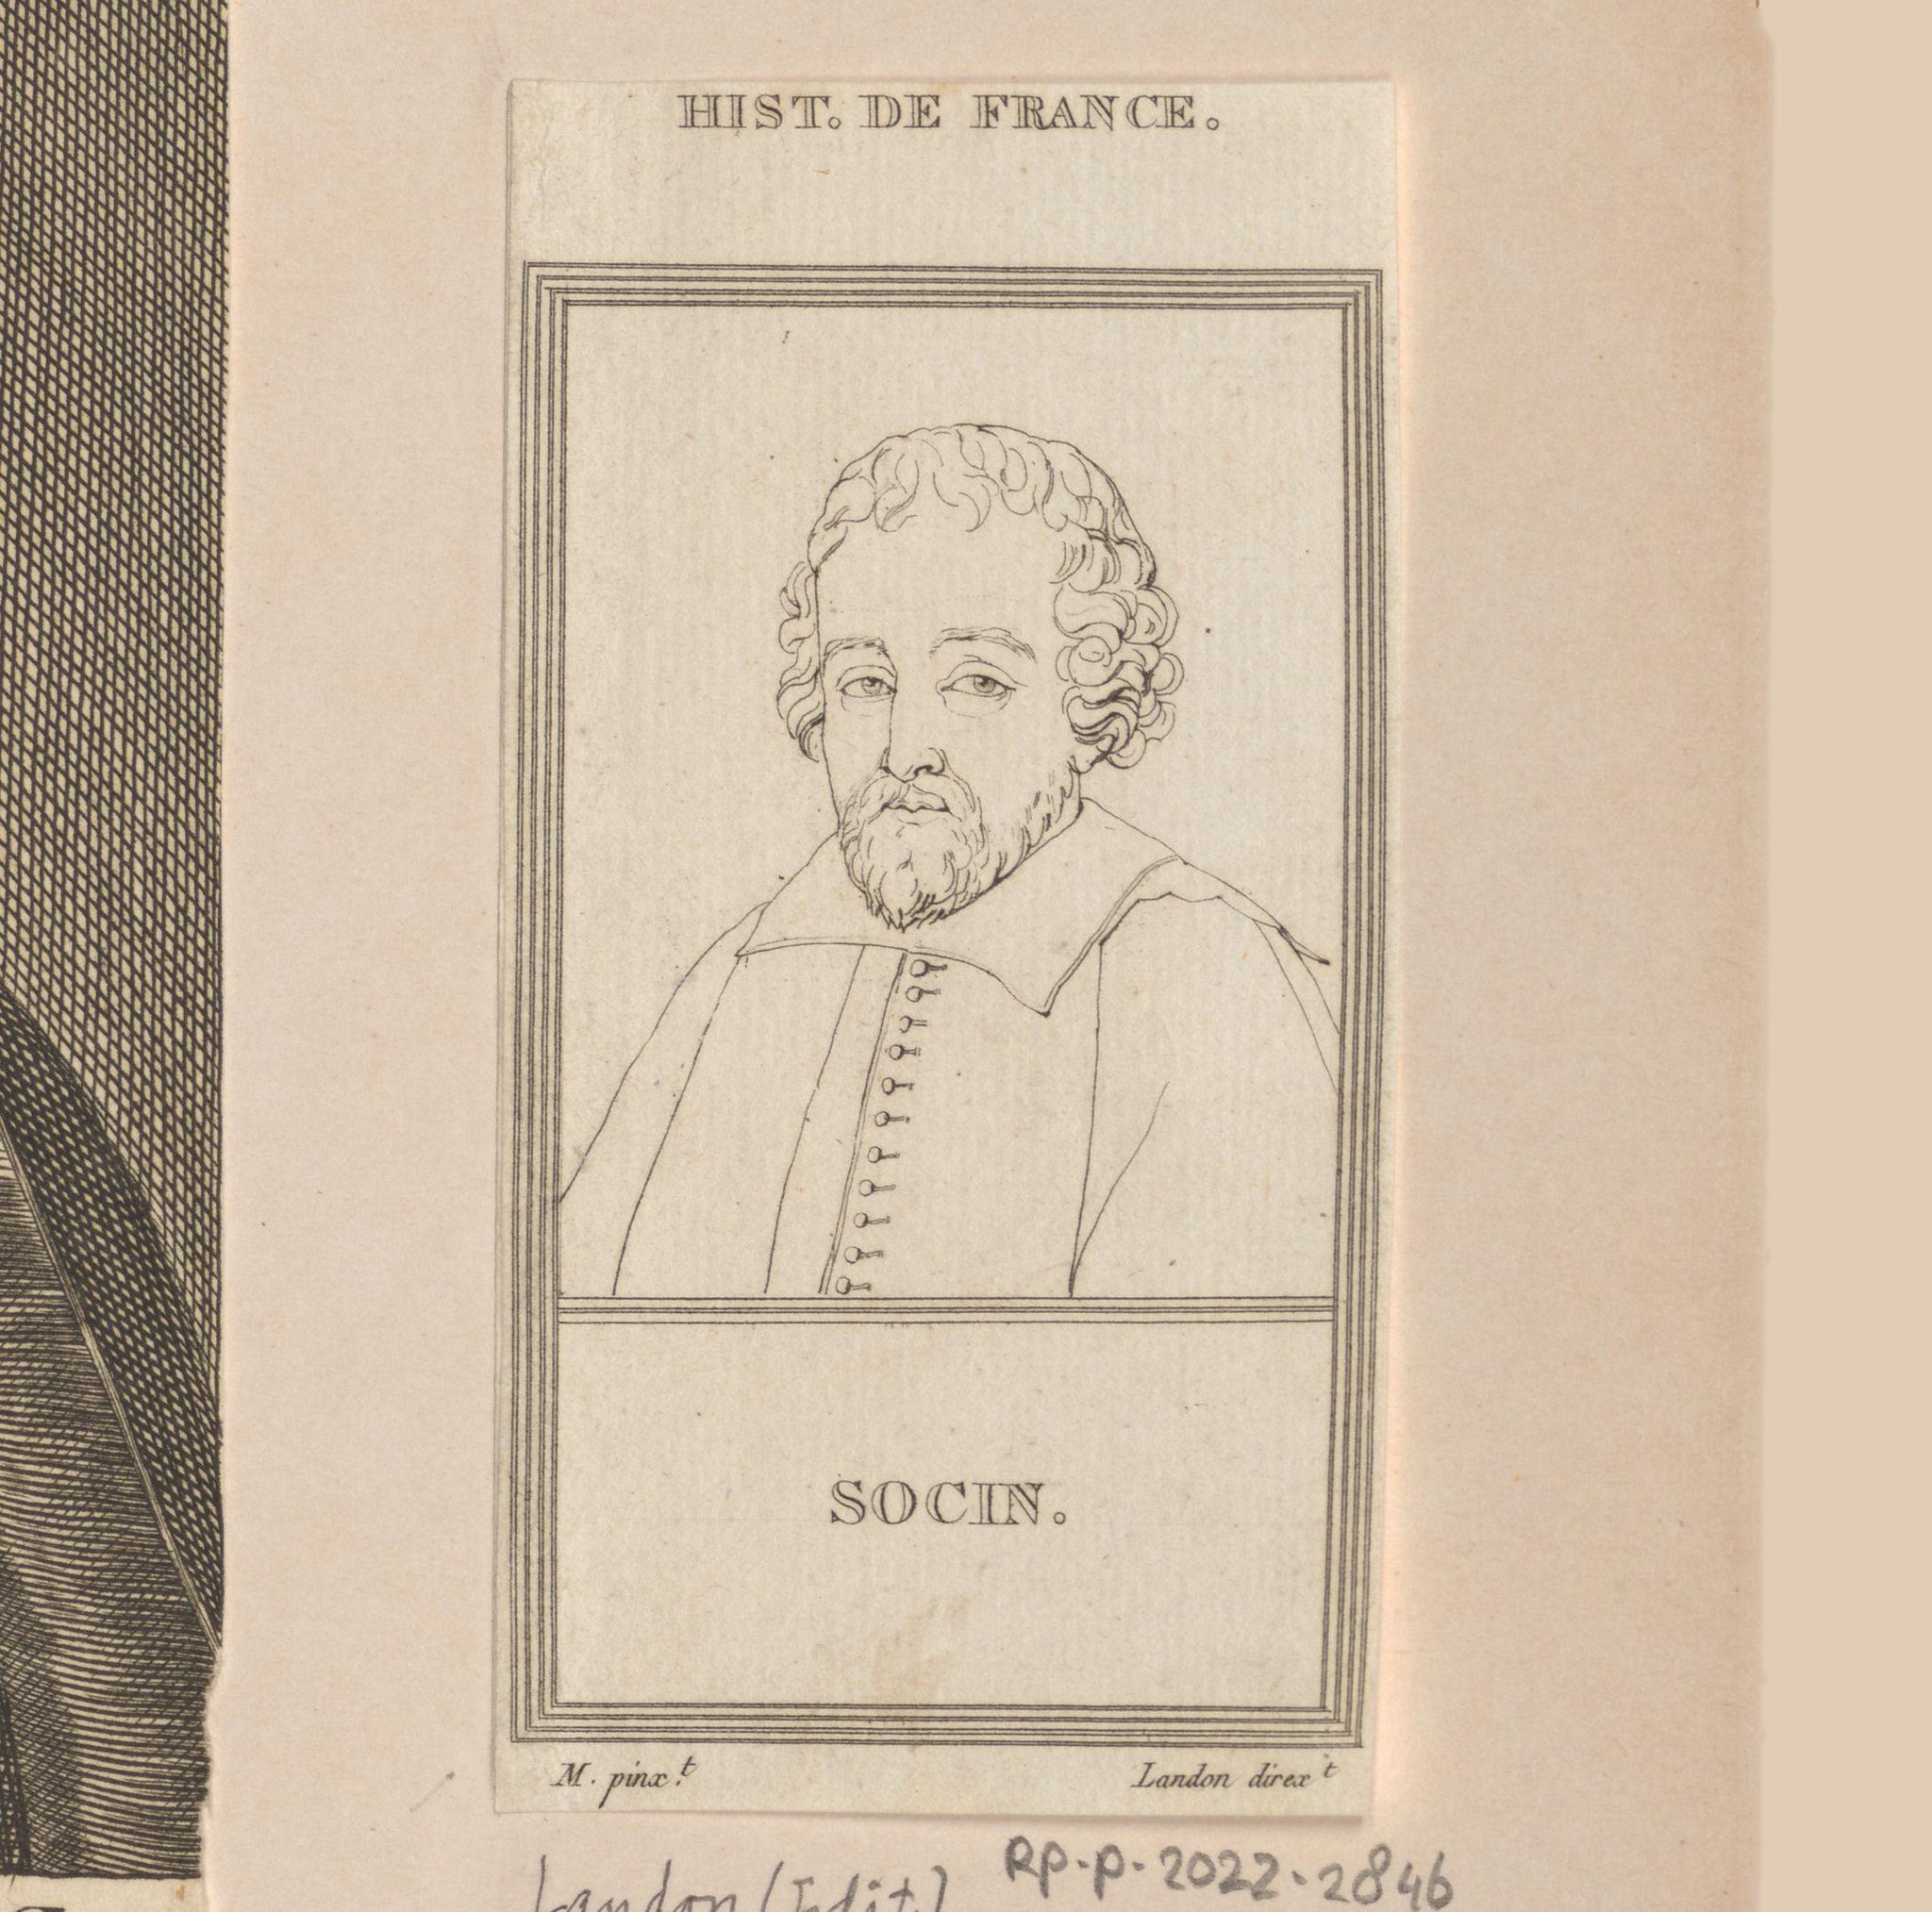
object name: print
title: Portret van Faustus Socinus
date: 1808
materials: paper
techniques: etching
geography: paris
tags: theologian, historical persons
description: Prent waarschijnlijk uit: Landon, Charles Paul. Galerie historique des hommes les plus célèbres (...). Parijs: Imprimerie des Annales du Musée, 1808, dl. 9.